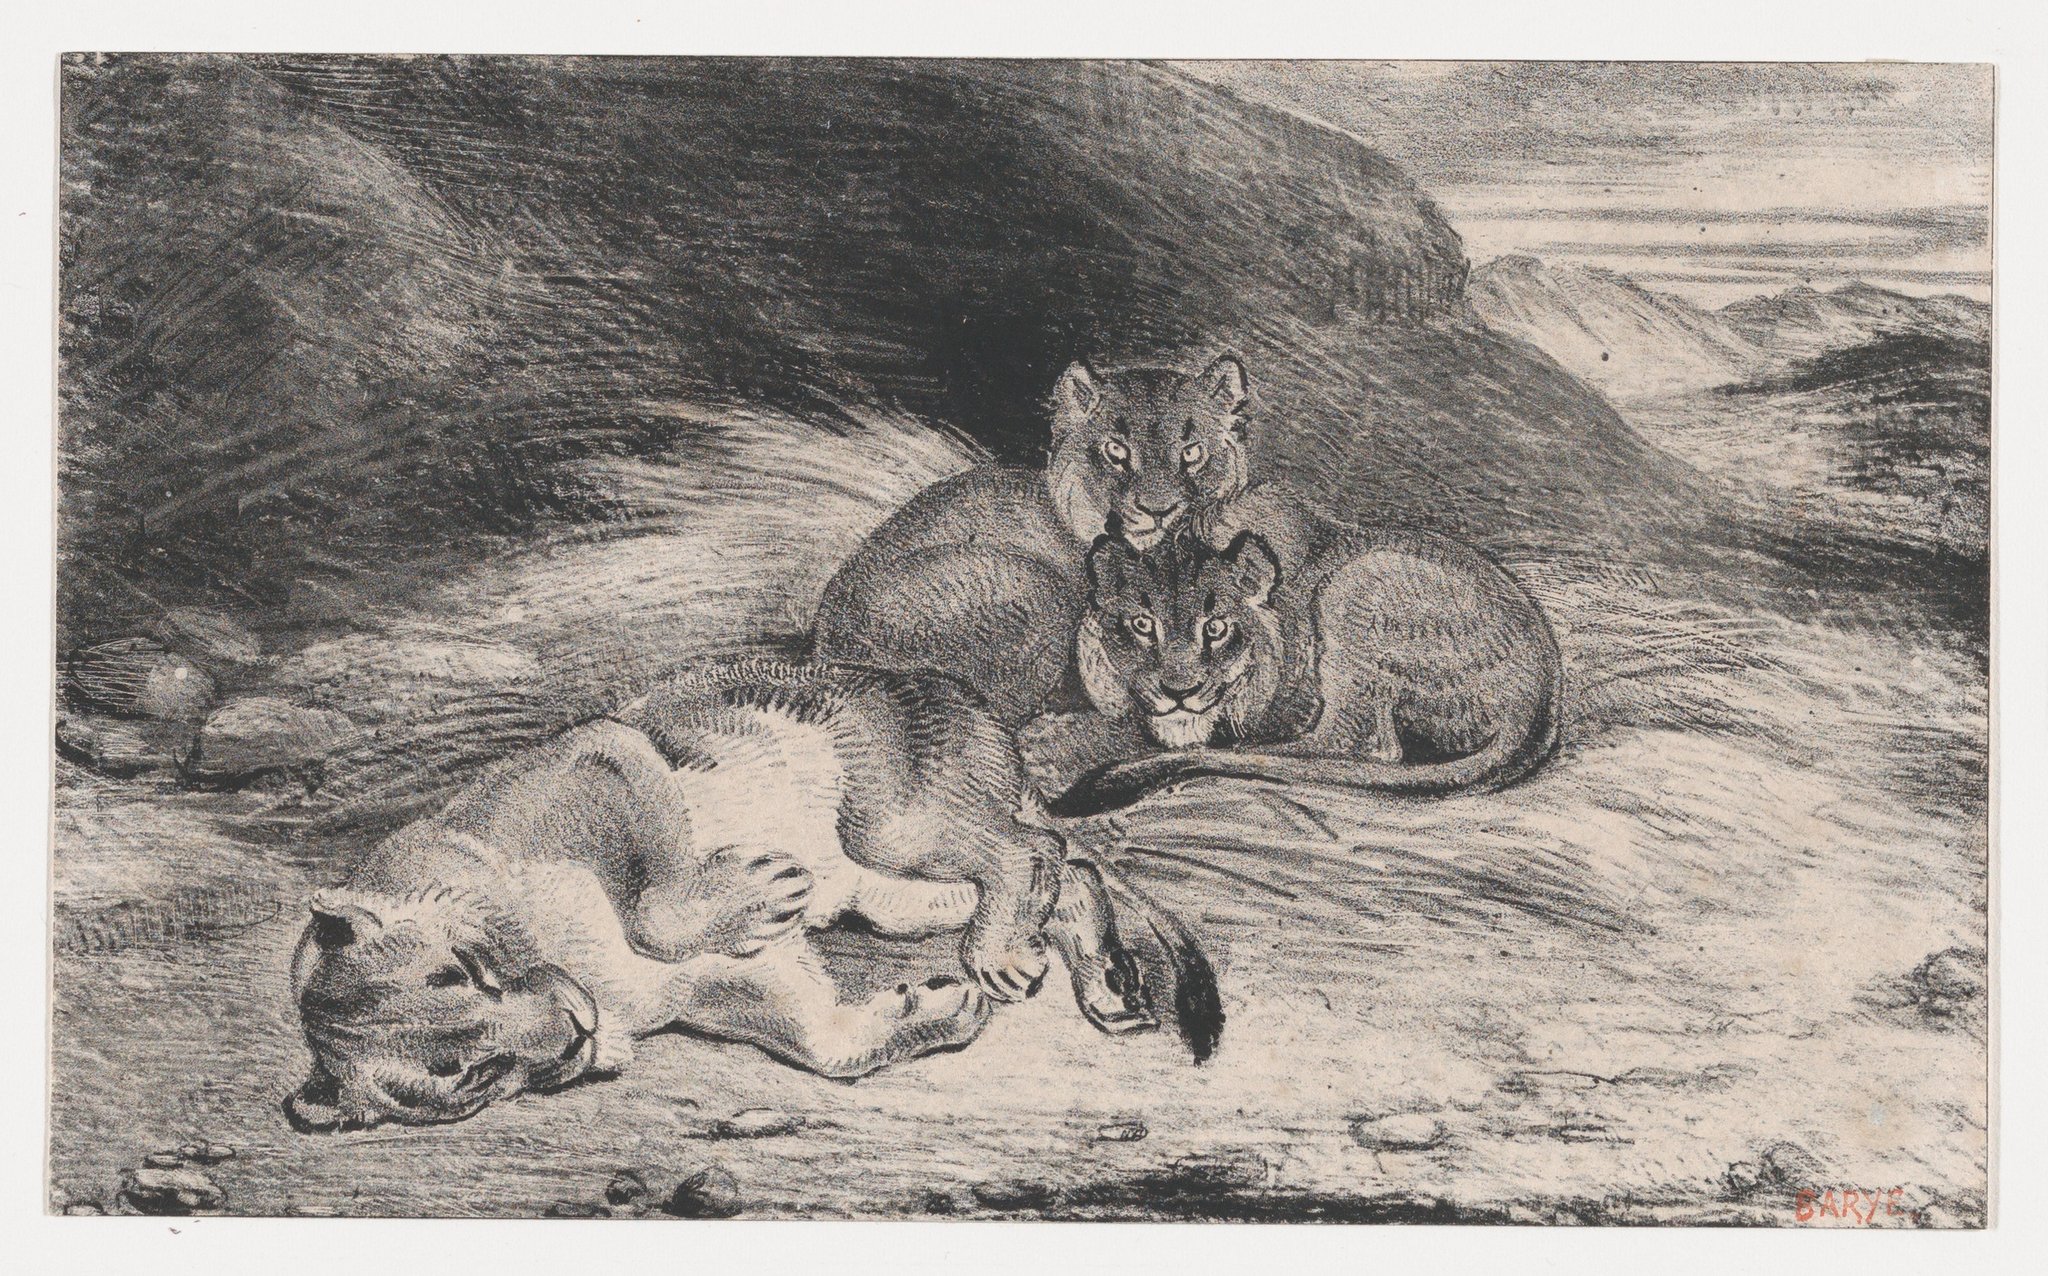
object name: print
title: Lioness and Cubs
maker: antoine-louis barye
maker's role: artist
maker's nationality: french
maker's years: 1795-1875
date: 1832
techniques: lithograph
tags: lions